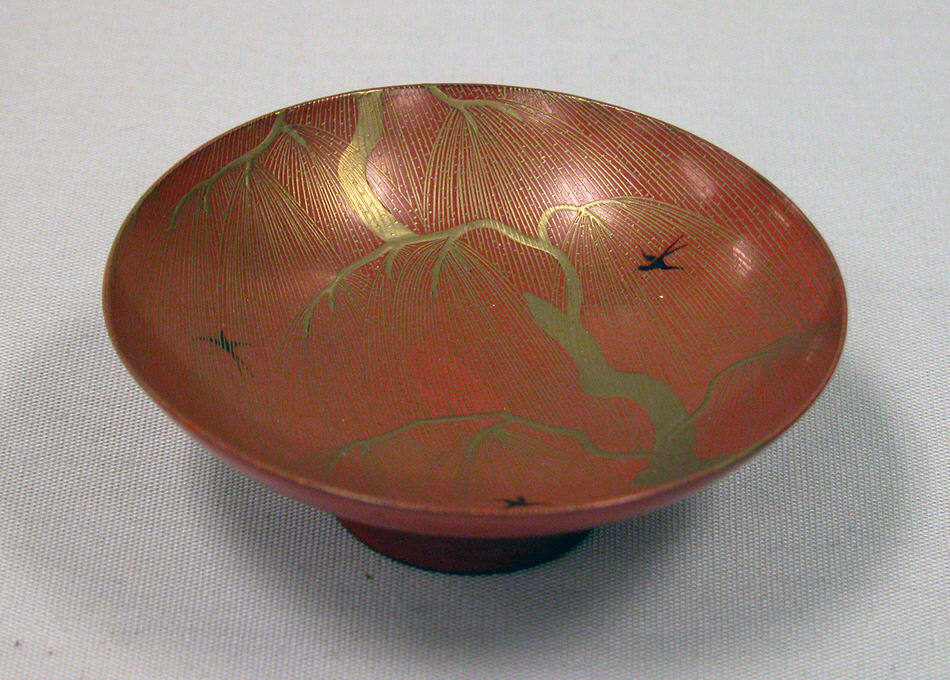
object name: wine cup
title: One of a Pair of Wine Cups (Sakazuki) with Willow and Swallows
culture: japanese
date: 1801-1900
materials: gold, lacquer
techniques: hiramakie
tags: birds,trees